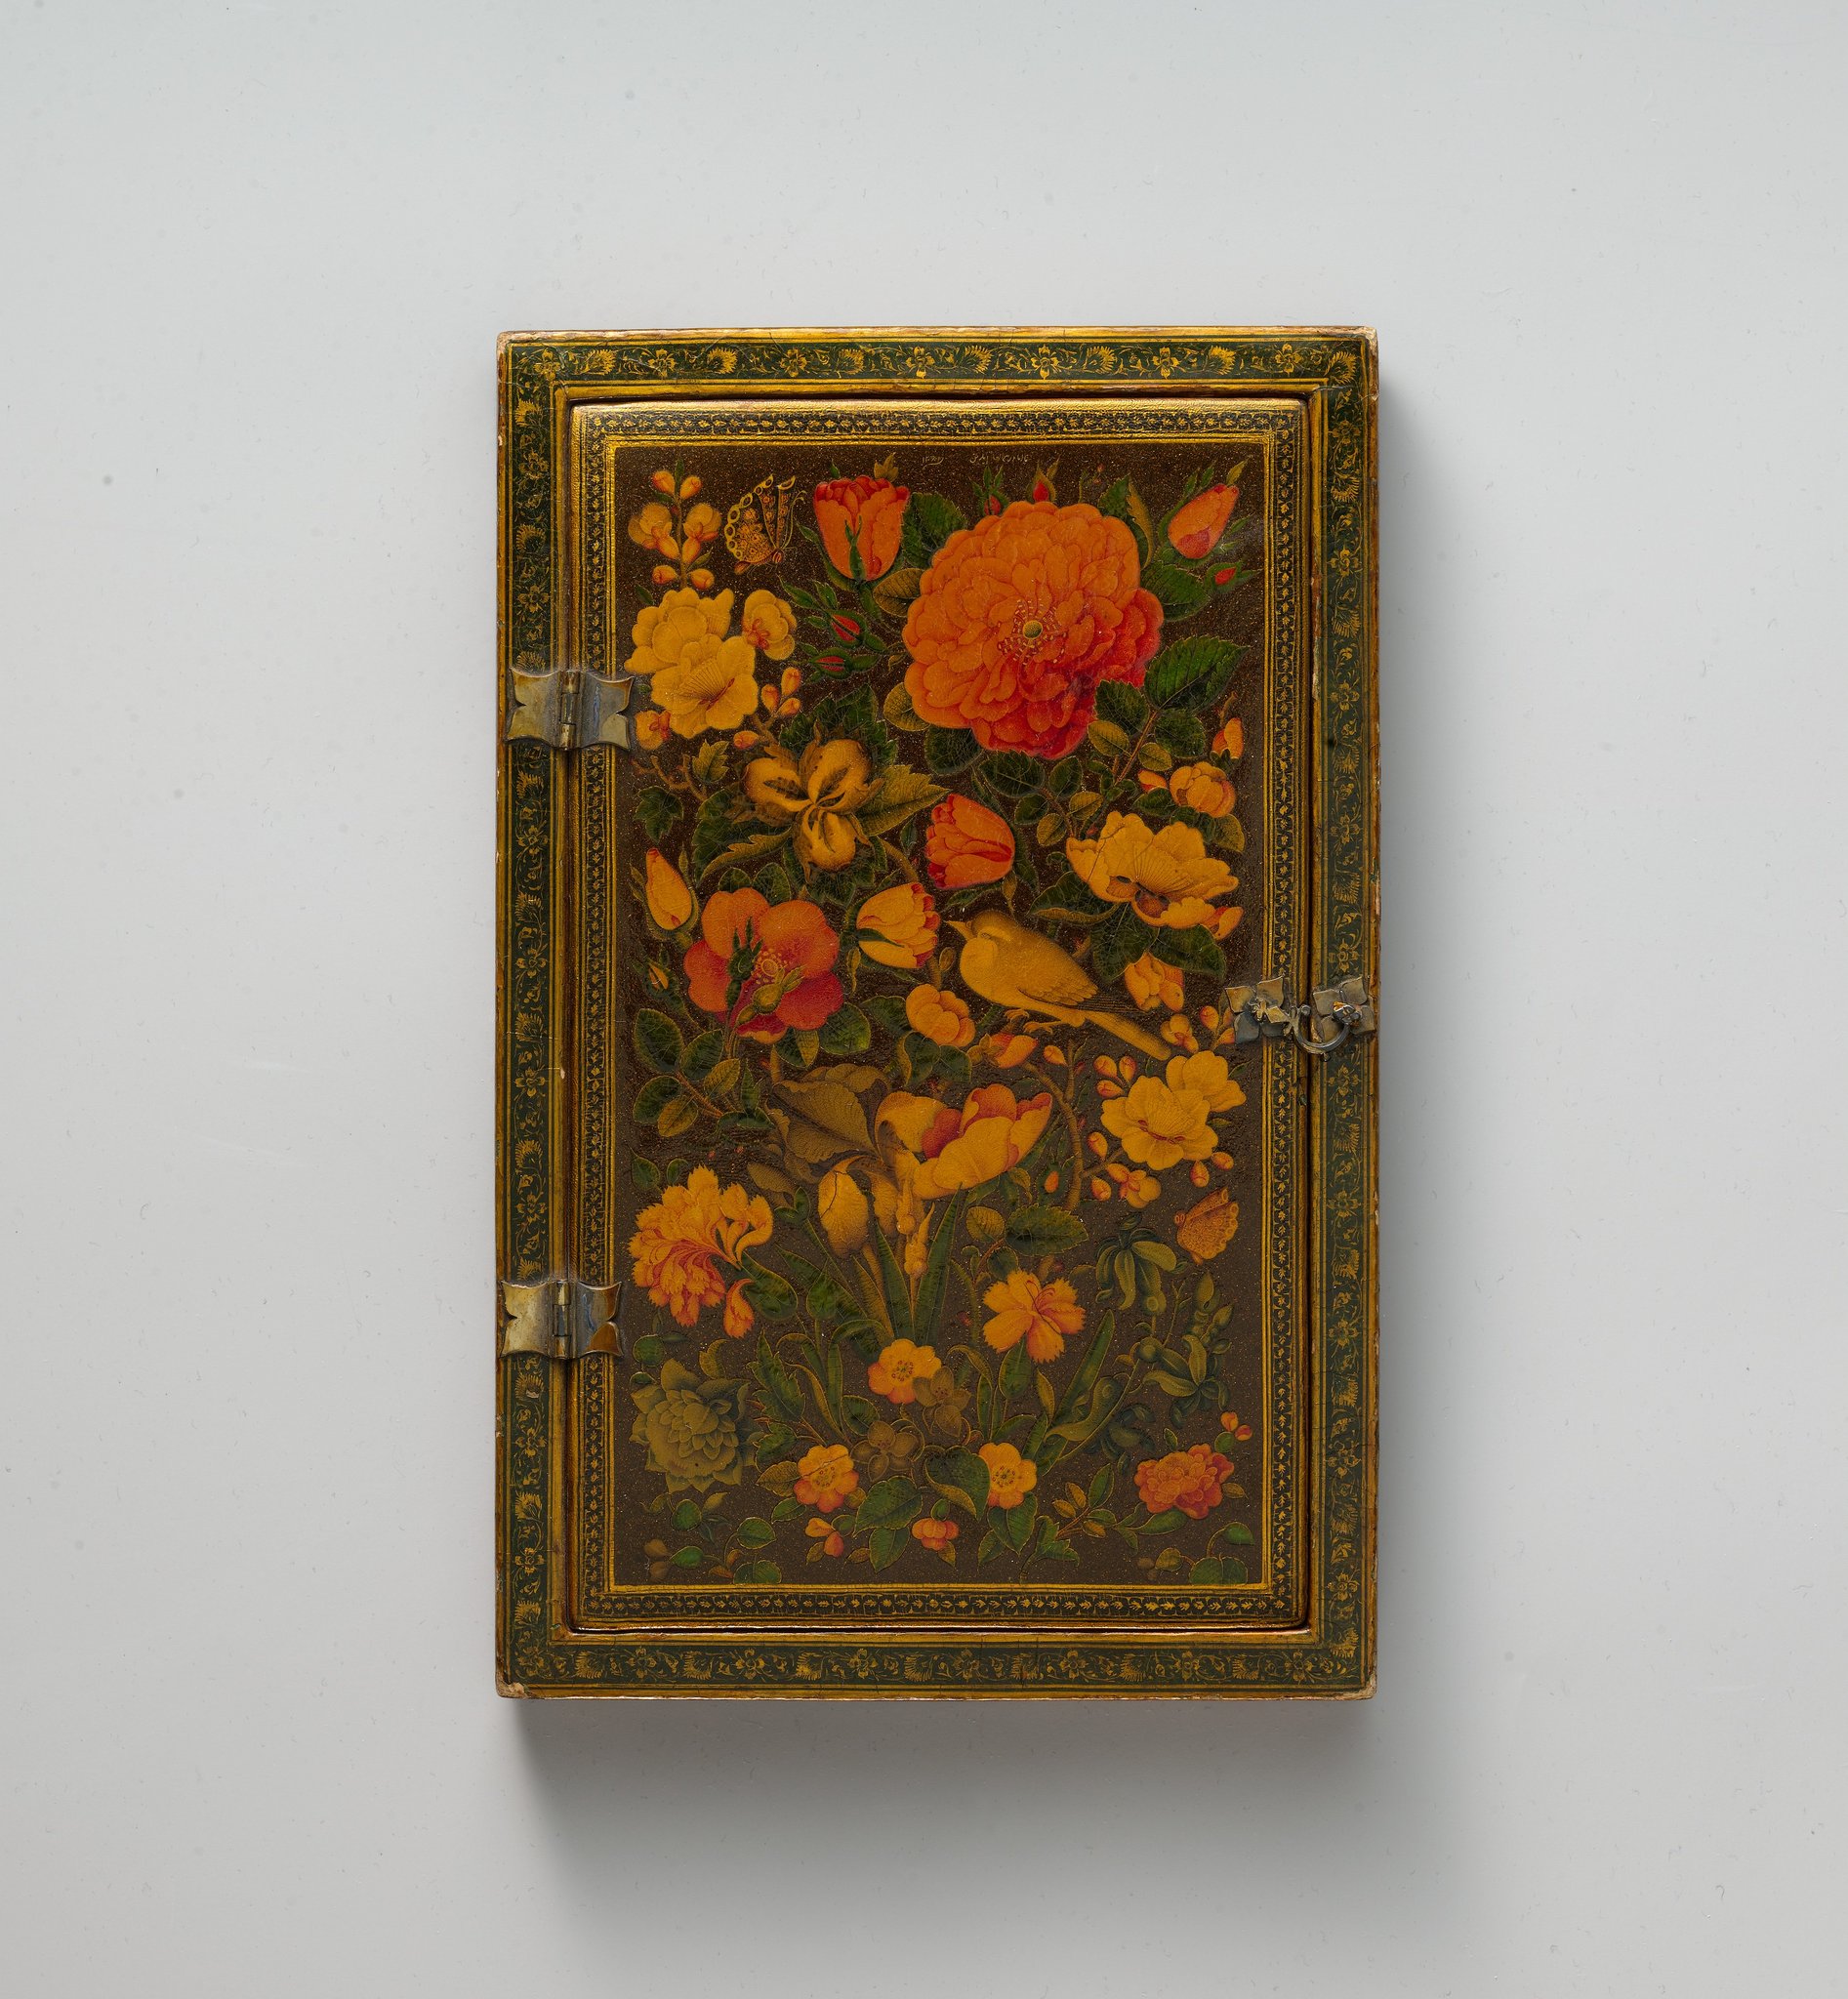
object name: mirror case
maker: zain al-'abidin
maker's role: artist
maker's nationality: iranian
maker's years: 1815-1899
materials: paper, board, watercolor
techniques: gilding, lacquer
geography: iran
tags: birds,butterflies,flowers